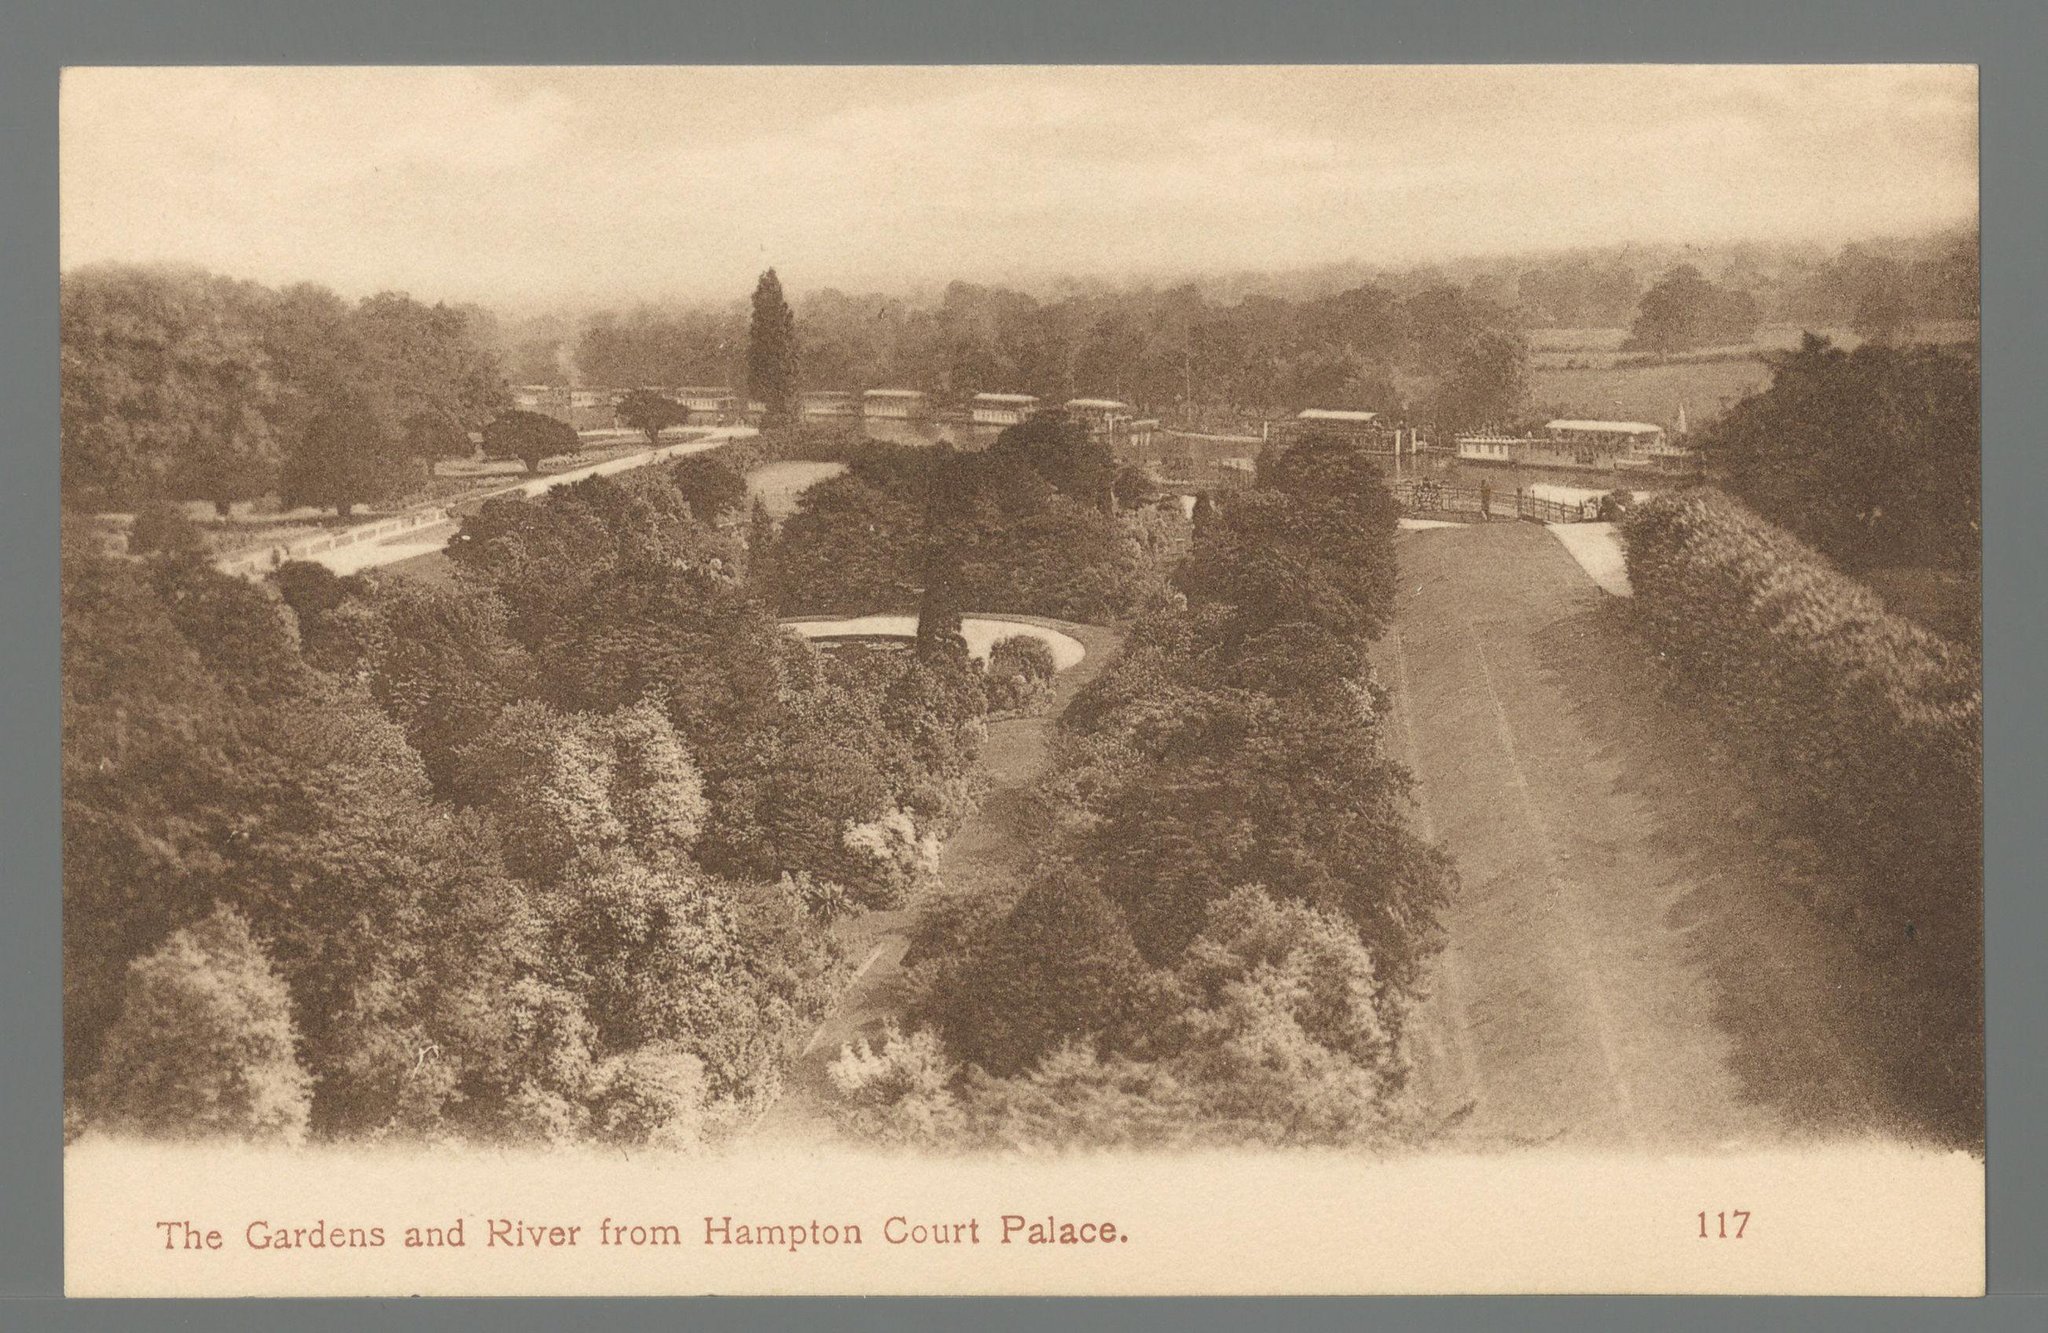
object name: ansichtkaart, prentbriefkaart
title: The Gardens and River from Hampton Court Palace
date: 1902-1930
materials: cardboard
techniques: photograph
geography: kingston-upon-thames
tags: river, garden, palace